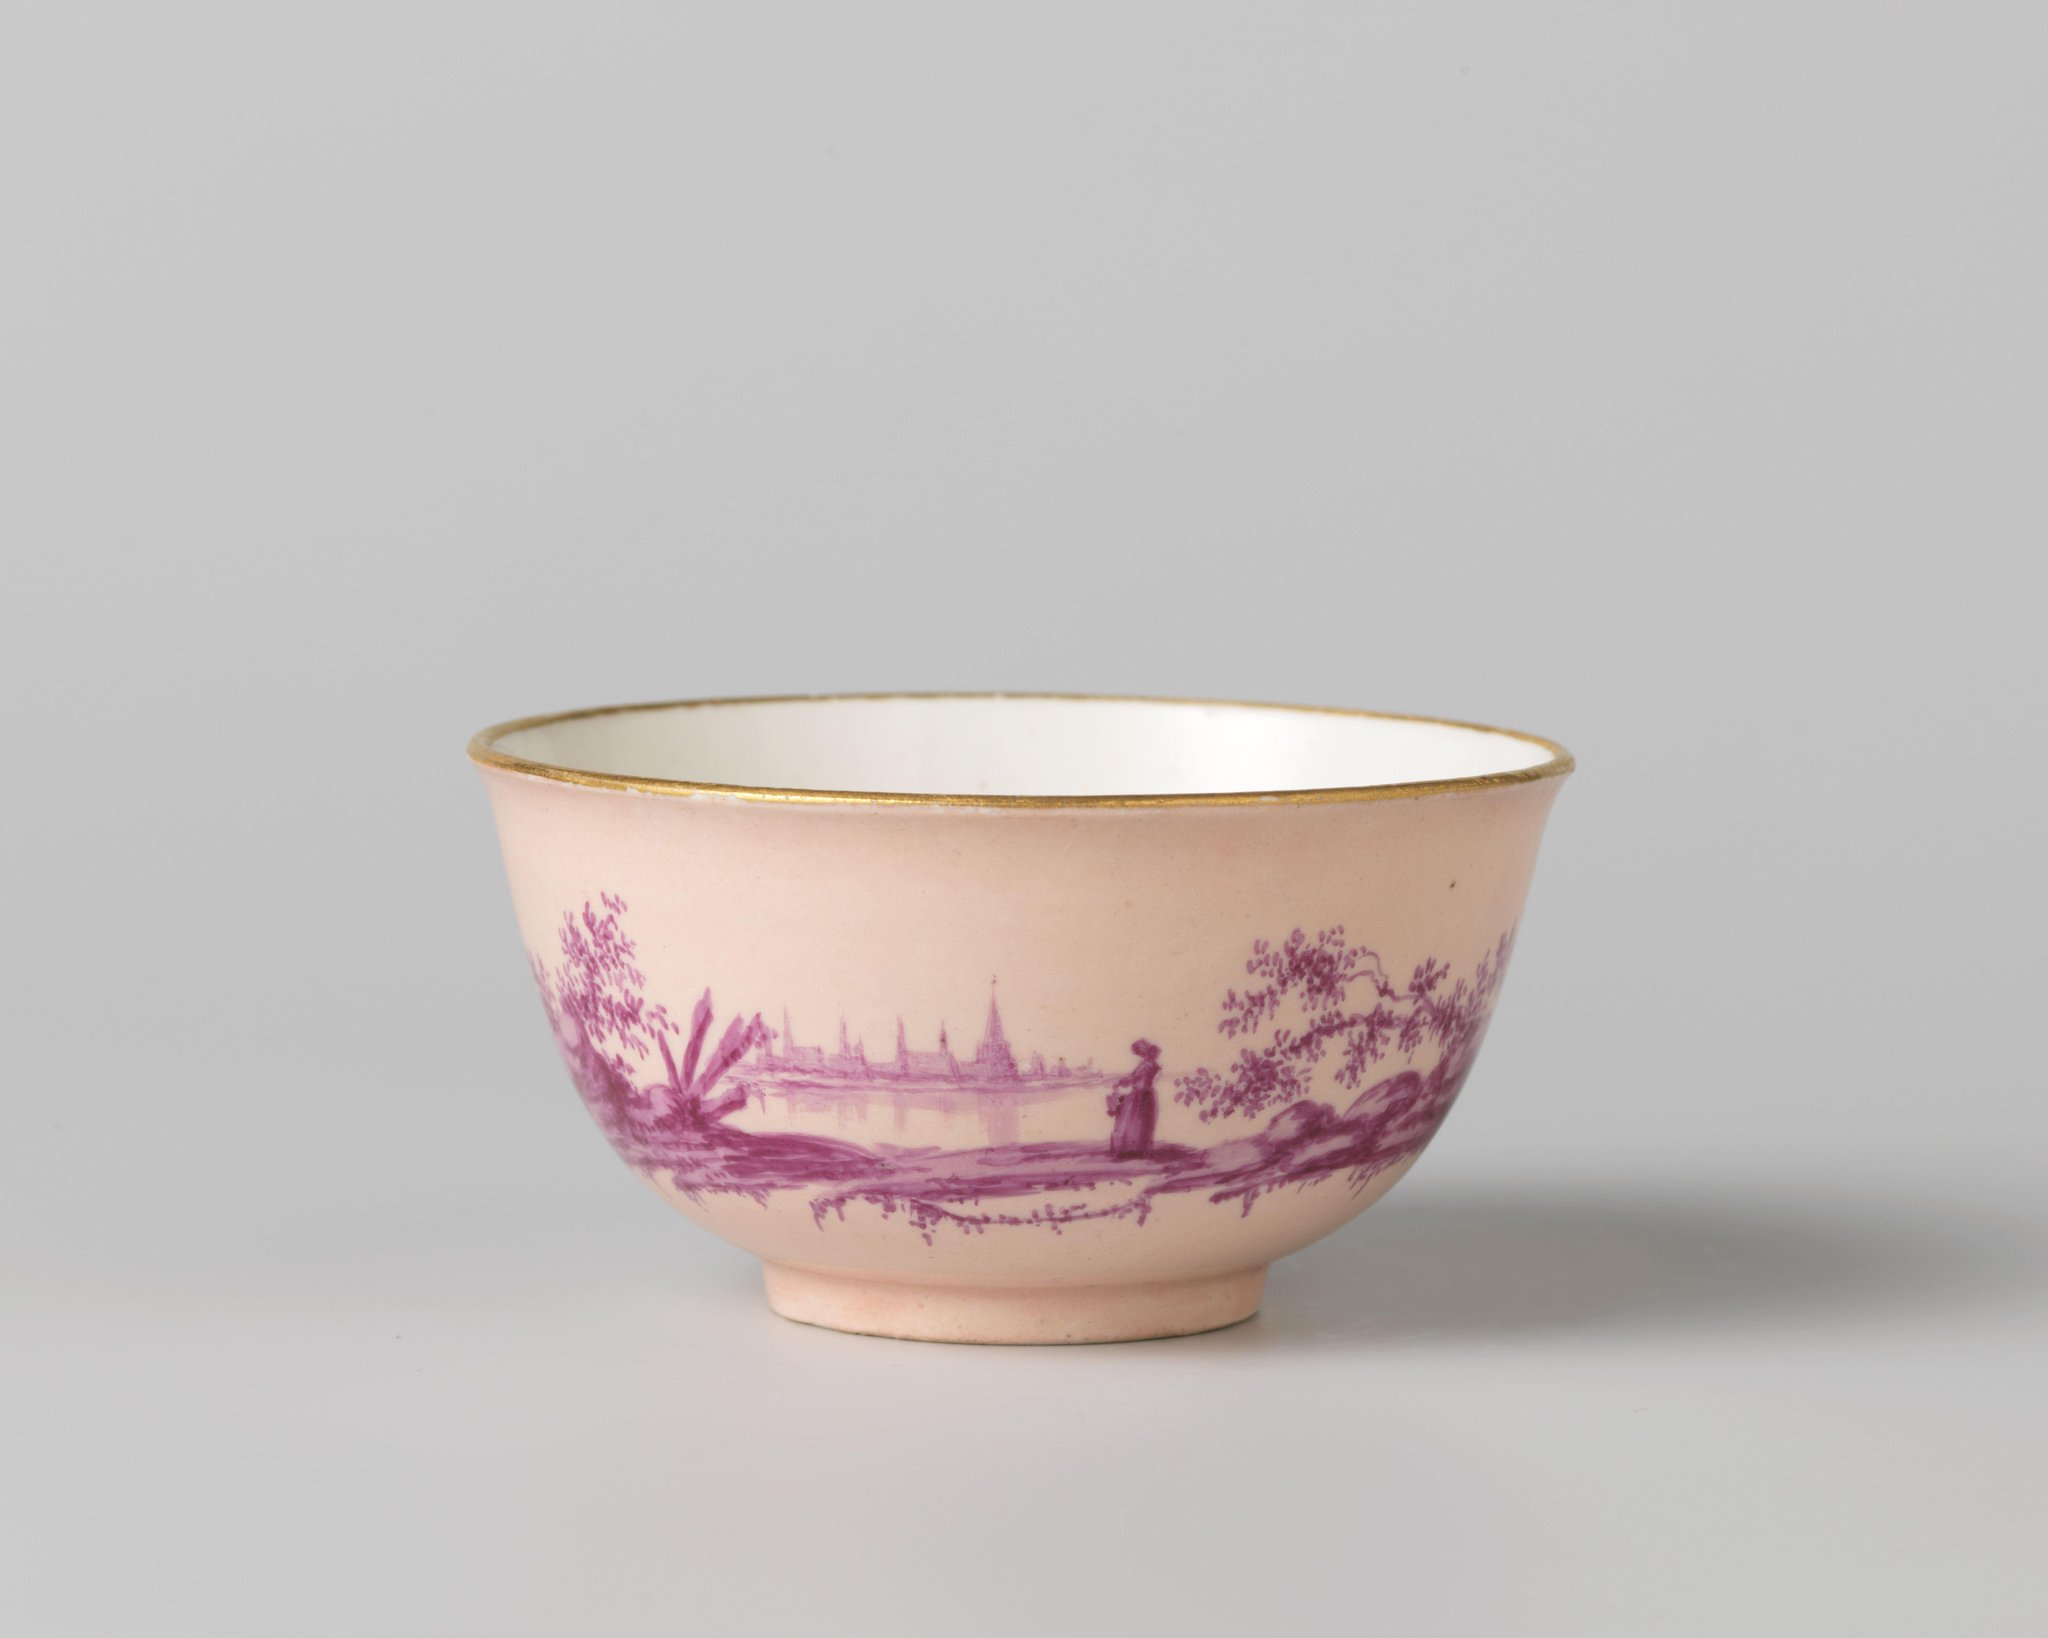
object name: tea cup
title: Theekop van een koffie- en theeservies, beschilderd met figuren in een rivierenlandschap in bietenrood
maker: Anonymous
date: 1774-1778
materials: porcelain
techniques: painted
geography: weesp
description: Parts of a tea and coffee service with pink ground. Porcelain. Loosdrecht, c. 1774 - 1776. Factory of Joannes de Mol.